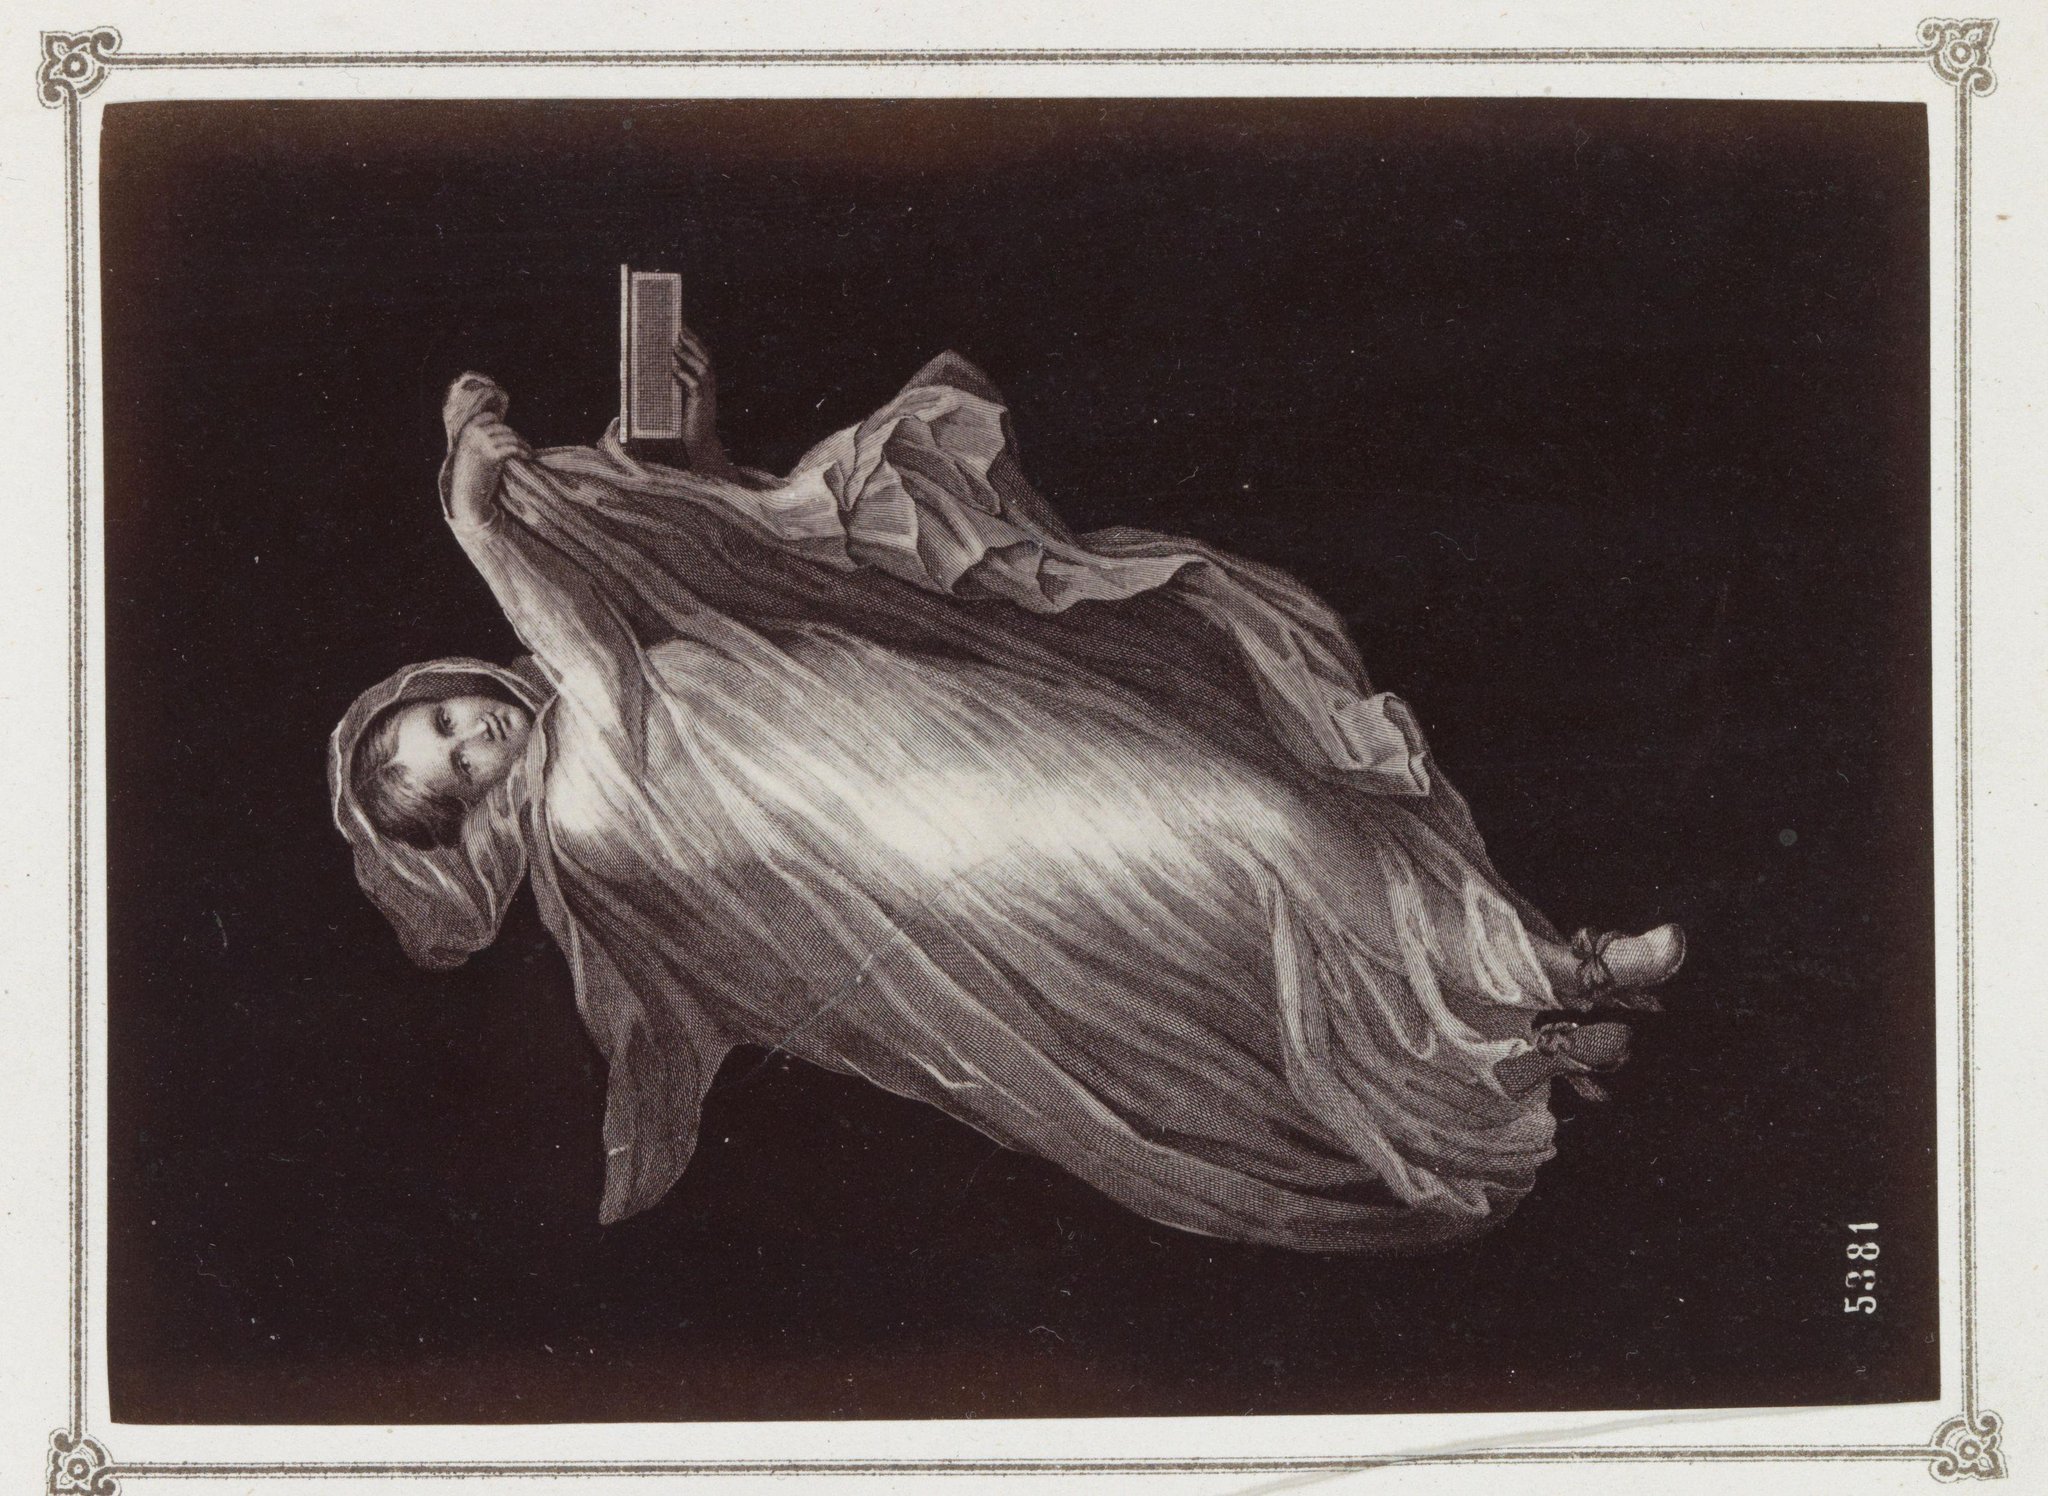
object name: reproduction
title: Fotoreproductie van (vermoedelijk) een prent, voorstellend een vrouwfiguur met een doos in de hand, mogelijk Pandora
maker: giorgio sommer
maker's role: fotograaf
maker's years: 1834-1914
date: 1860-1900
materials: paper, photographic support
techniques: albumen print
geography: pompeii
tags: (story of) pandora, standing figure - aa - female human figure, pompeii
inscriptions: number: ‘5381’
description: Onderdeel van Fotoalbum met opnames van opgravingen in Pompeï door Giorgio Sommer.